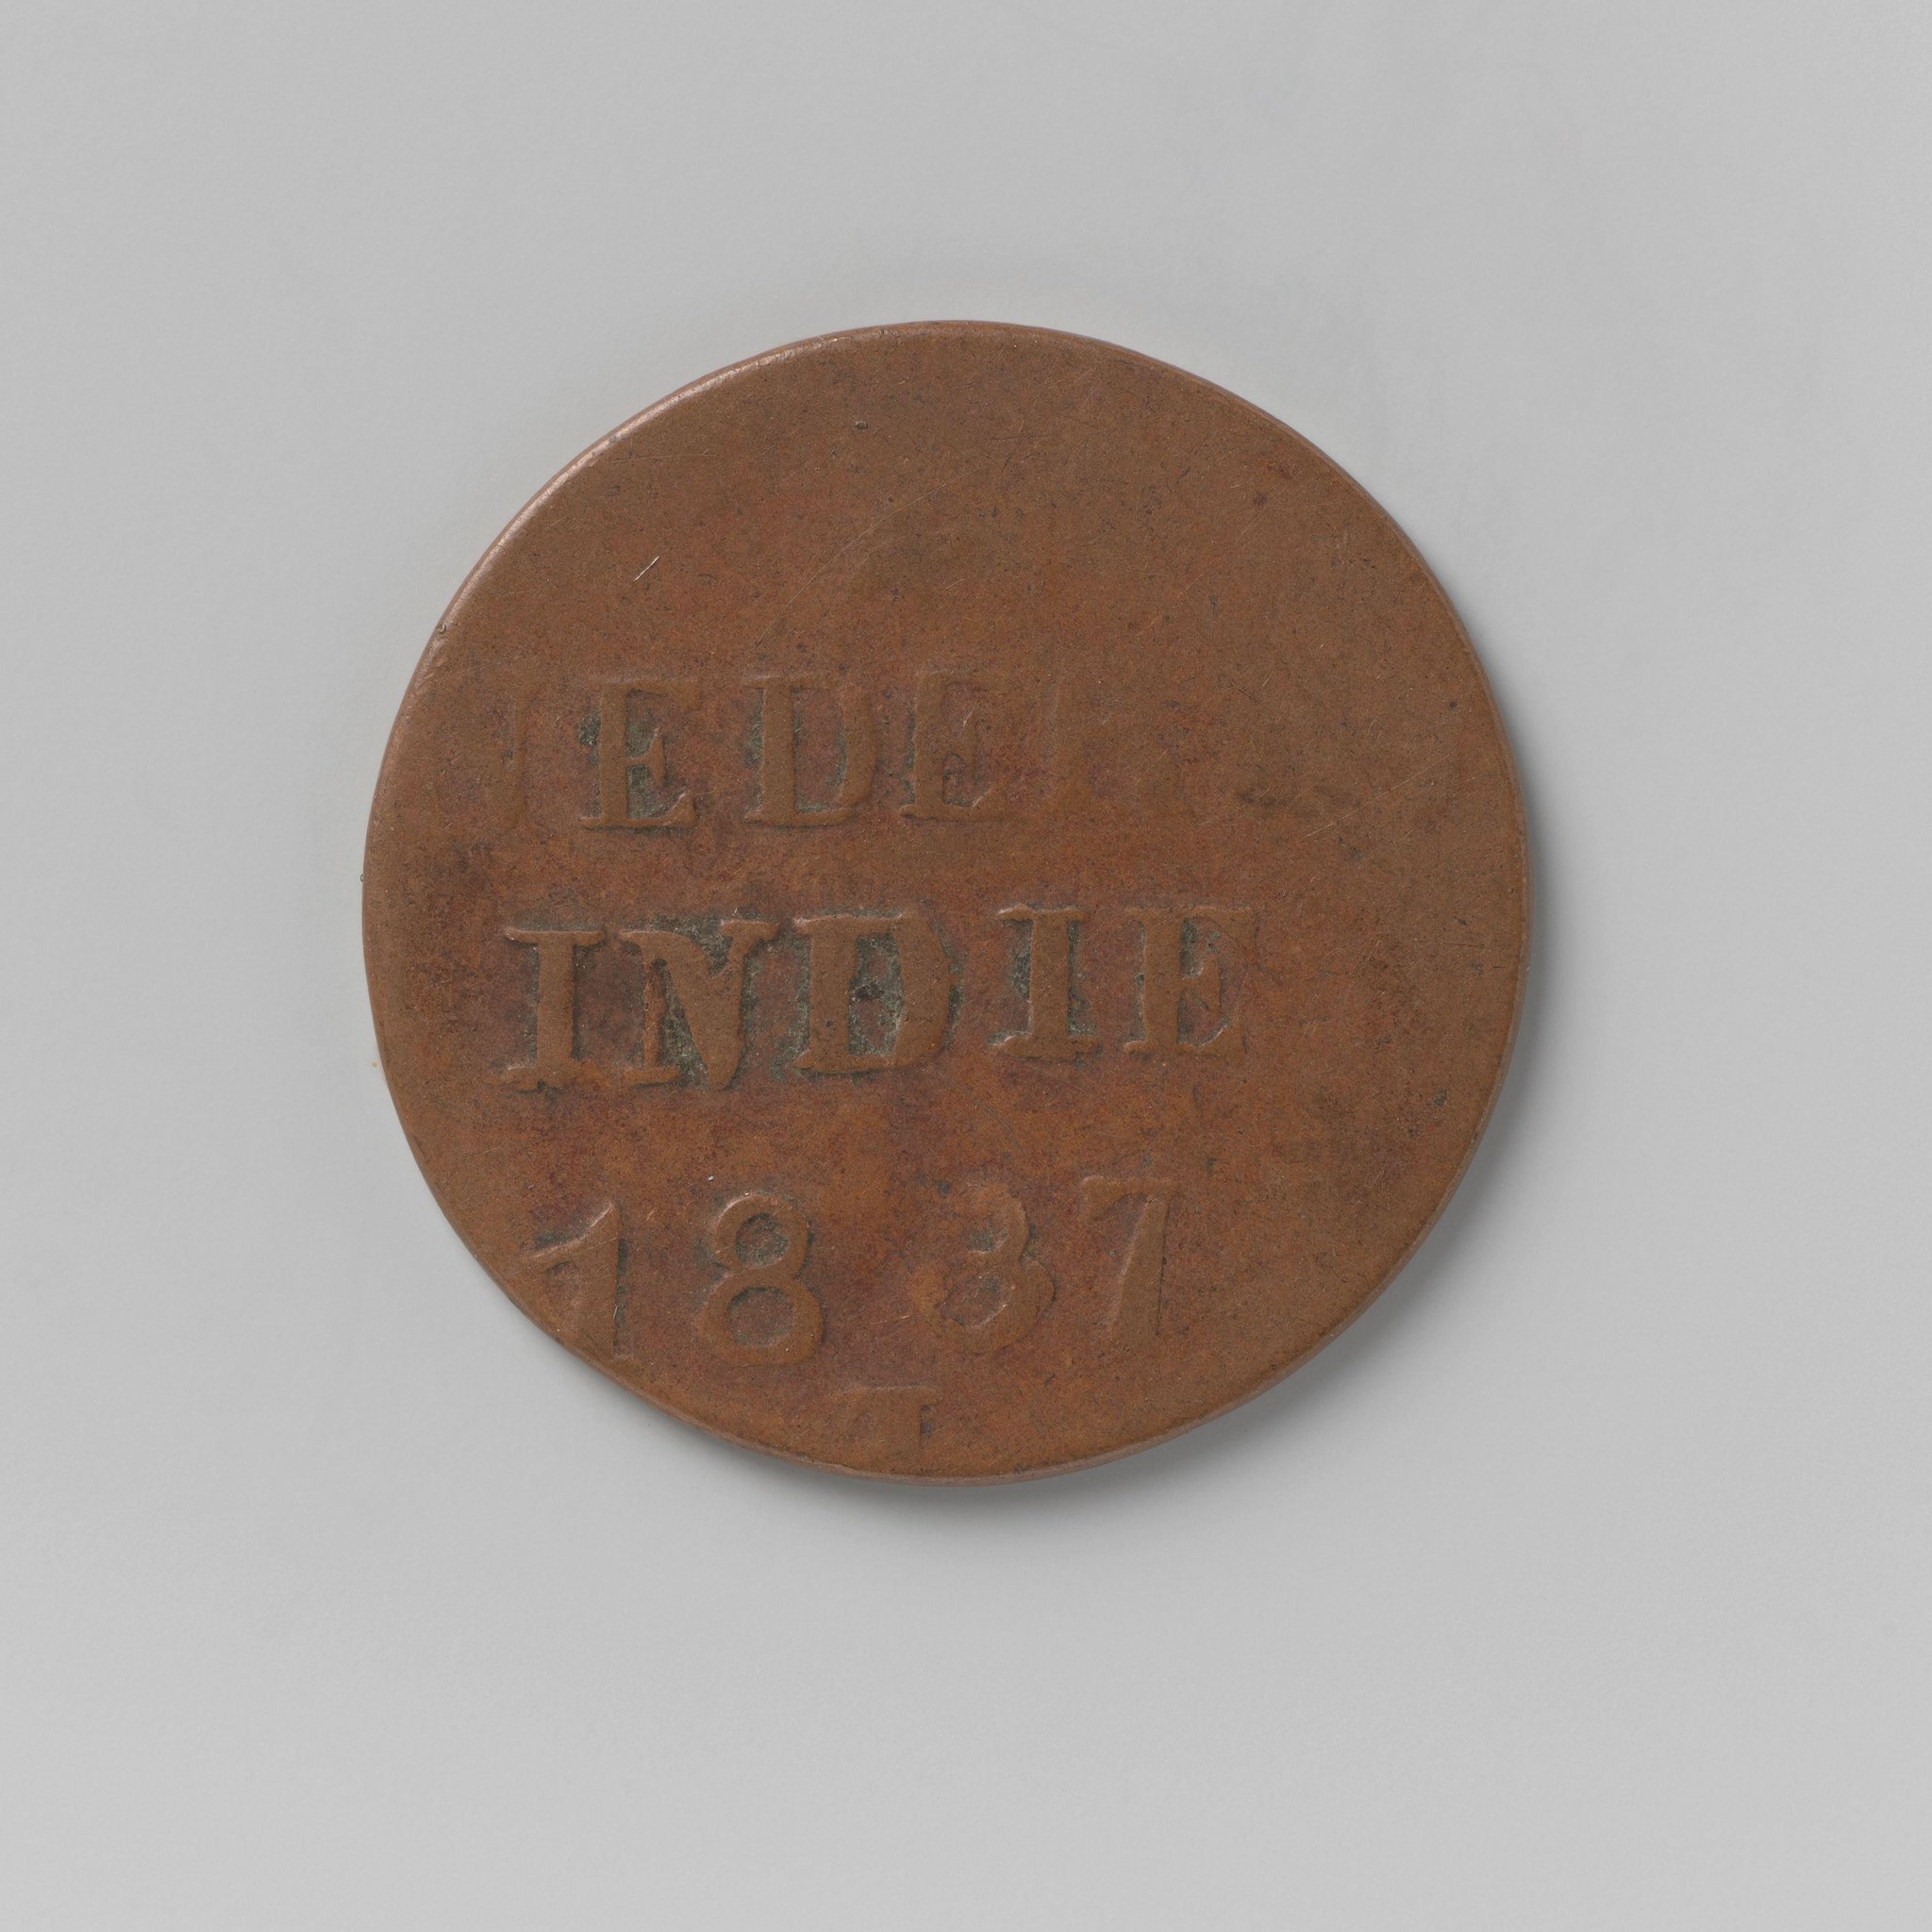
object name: coin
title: Cent van Nederlands Indië,1837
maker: william i of the netherlands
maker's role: koning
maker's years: 1772-1843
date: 1837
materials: copper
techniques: striking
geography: surabaya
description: Koperen munt. Voorzijde: tussen waarde-aanduiding I CT. gekroond rijkswapenschild. Keerzijde: tweeregelig opschrift, waarboven muntteken en waaronder jaartal. Daaronder letter J [=muntmeester Jeekel]. Gladde rand.